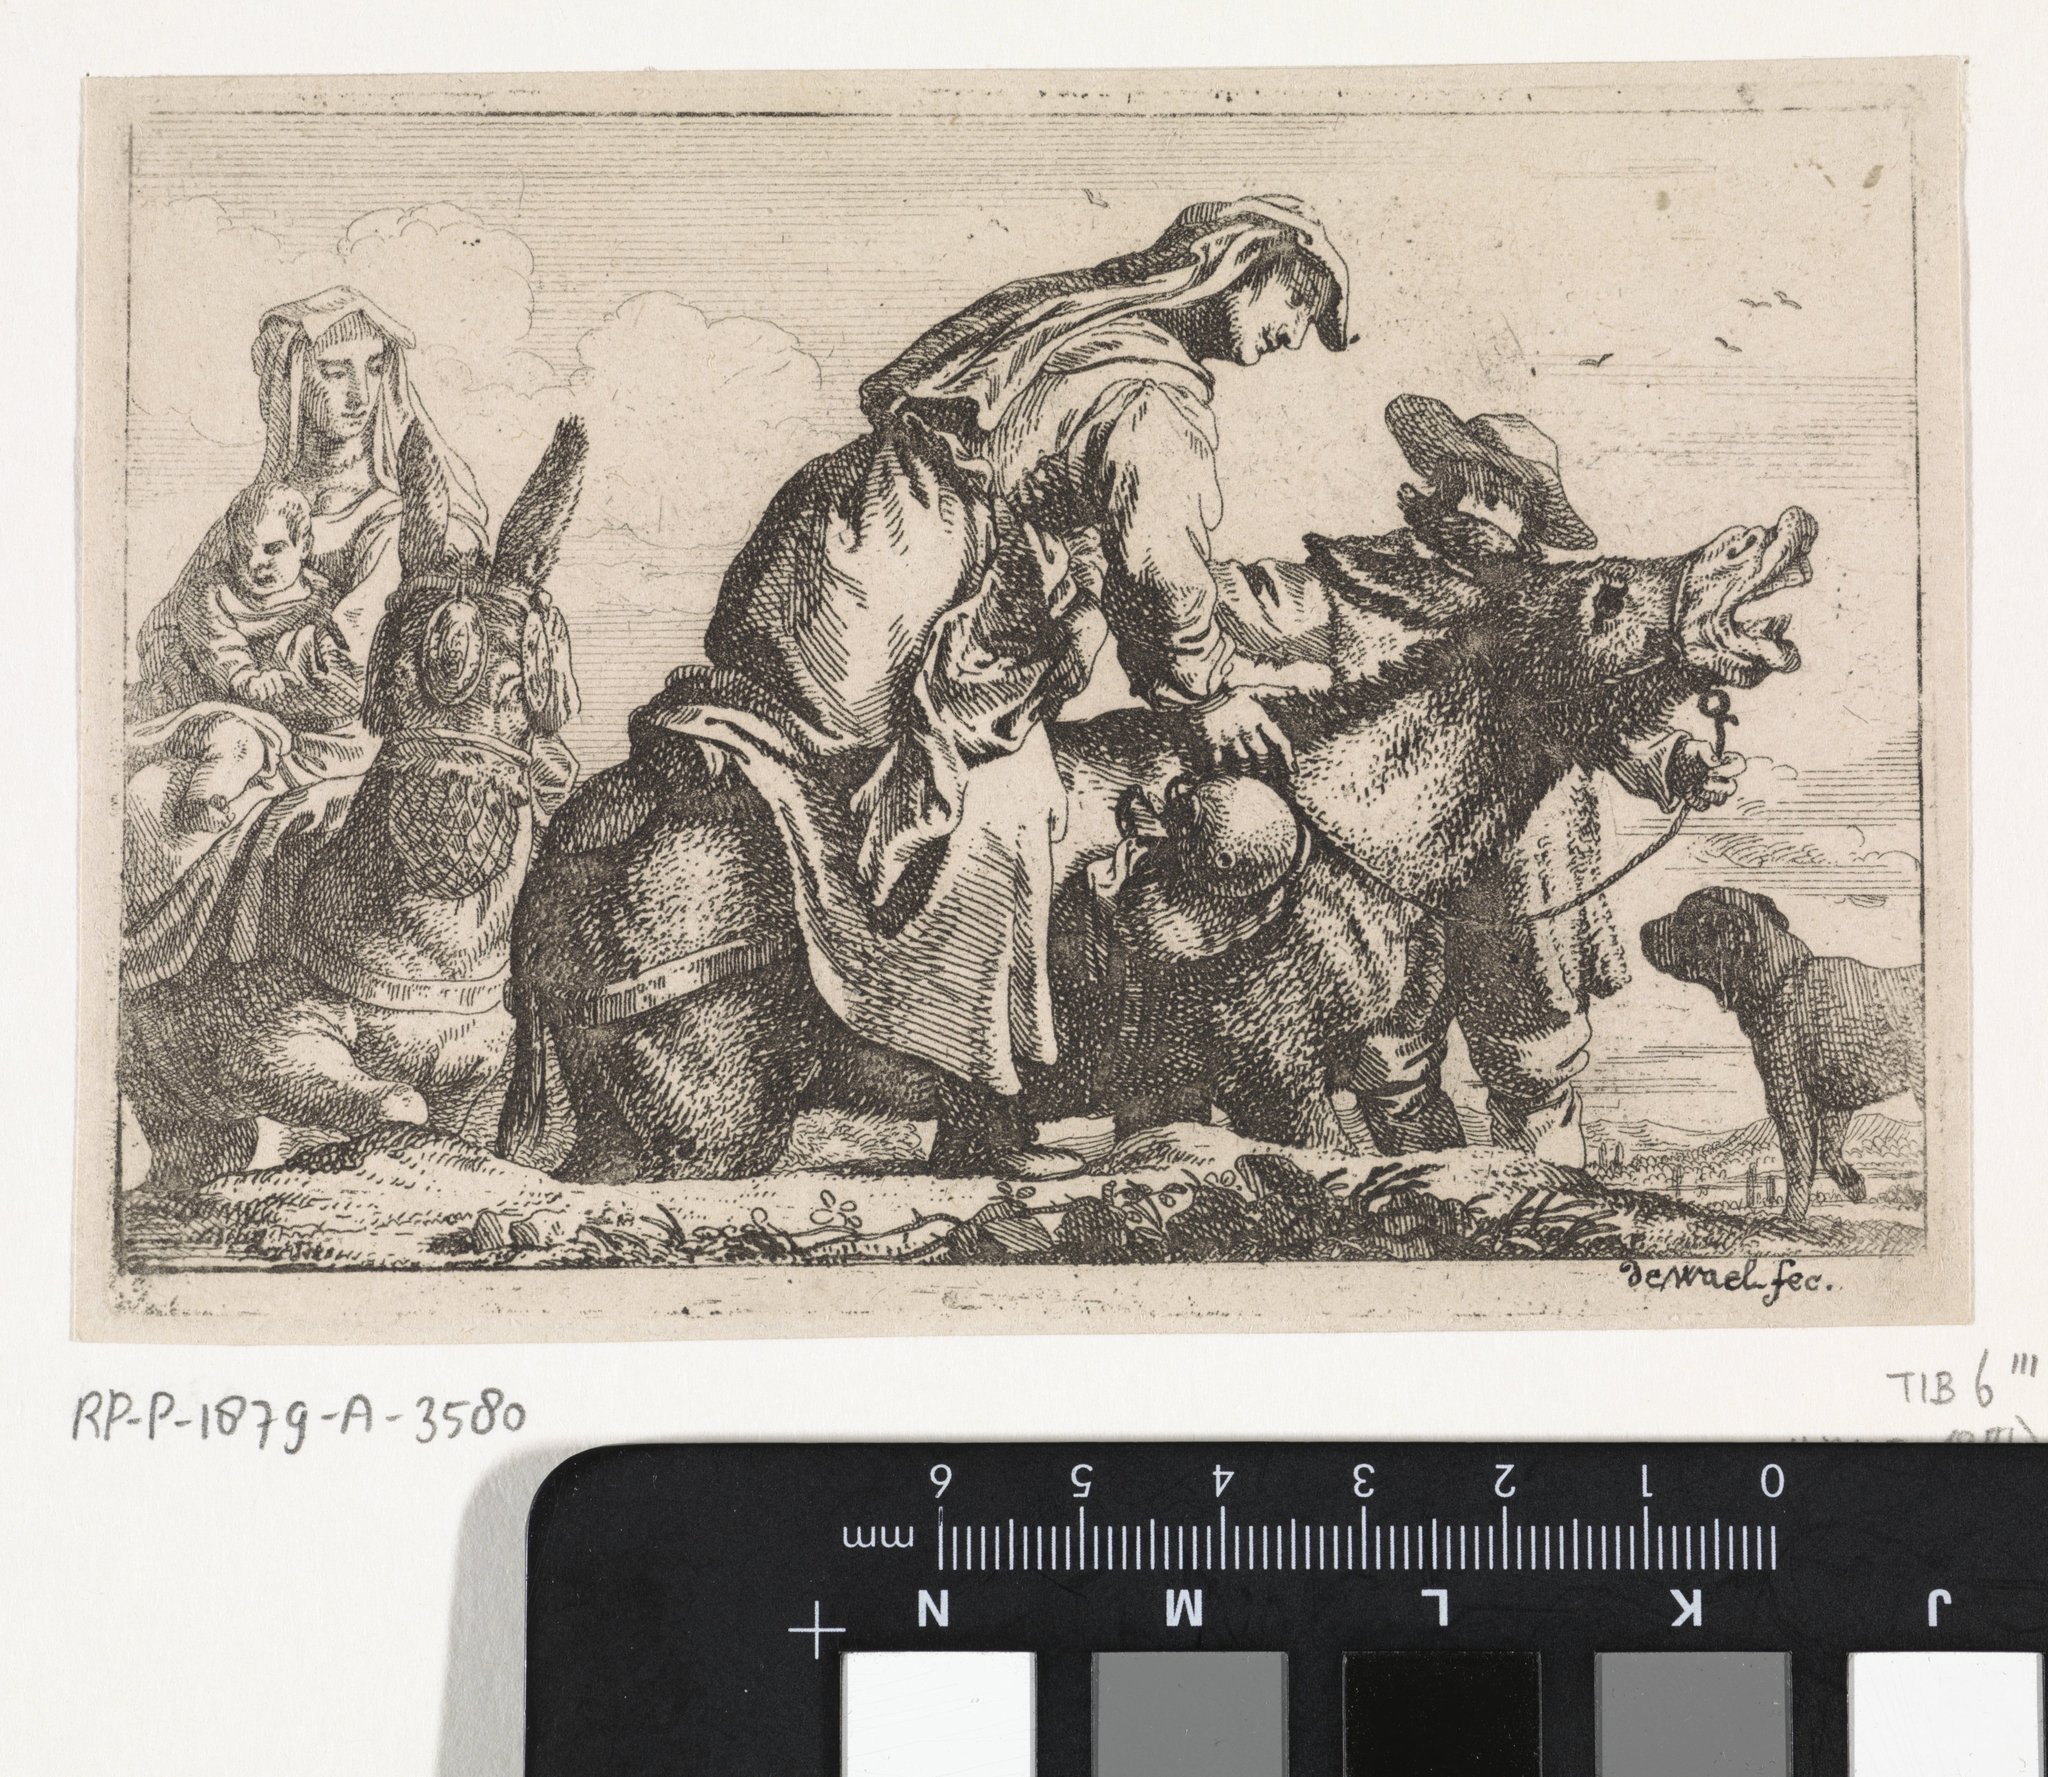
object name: print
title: Vrouw bestijgt ezel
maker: jan baptist de wael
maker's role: print maker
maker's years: 1632-1669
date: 1642-1669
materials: paper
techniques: etching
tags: ass, donkey, mother and child(ren), woman and child(ren) (family group)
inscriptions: collector's mark: Lugt 2228, inscription: ‘de Wael fec.’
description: Een man helpt een vrouw die een balkende ezel bestijgt. Linksachter een vrouw die samen met haar kind op een ezel zit.